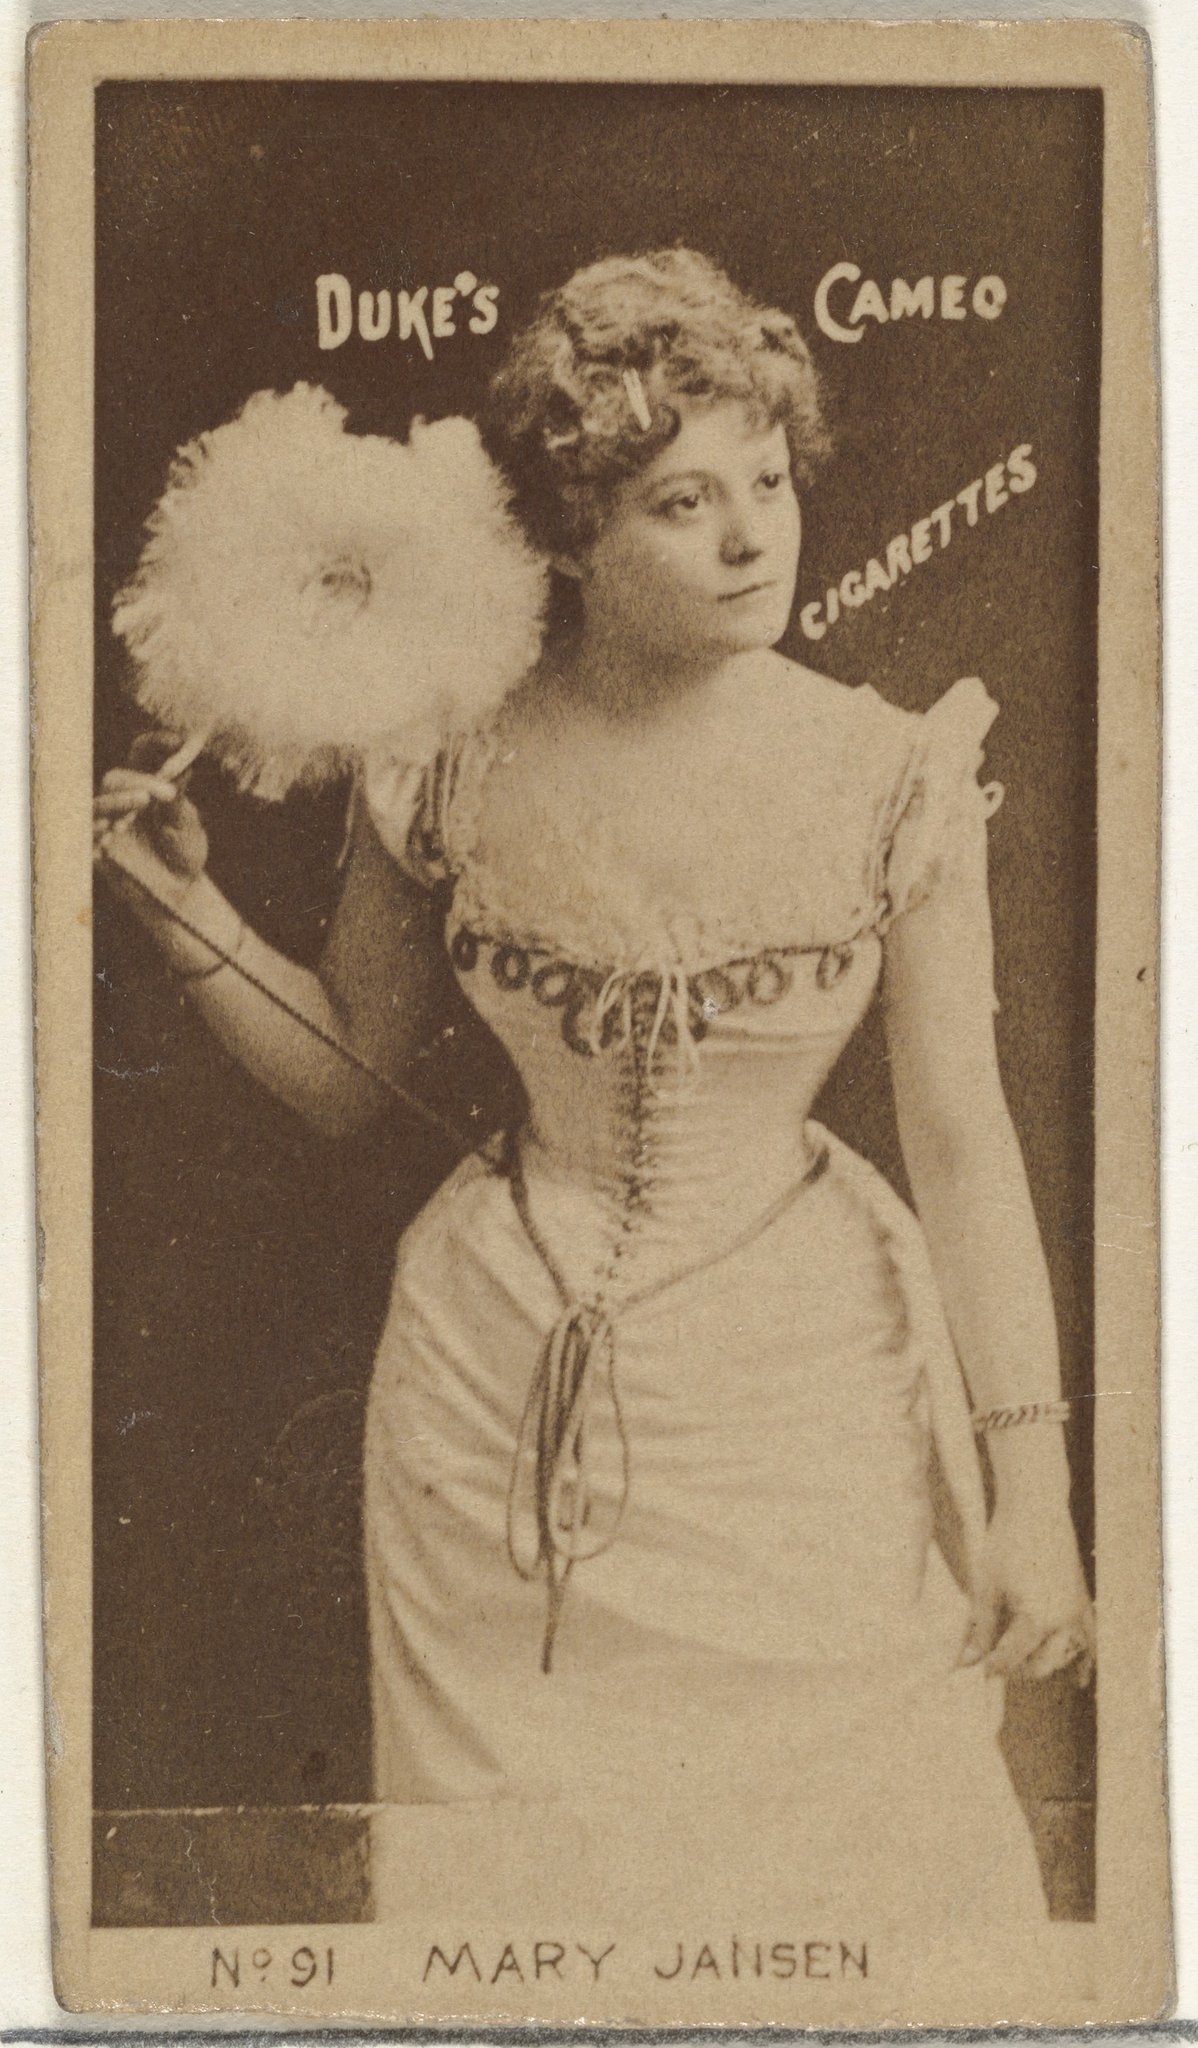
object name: photograph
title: Card Number 91, Marie Jansen, from the Actors and Actresses series (N145-4) issued by Duke Sons & Co. to promote Cameo Cigarettes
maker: w. duke, sons & co.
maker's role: publisher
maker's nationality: american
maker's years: 1870-1920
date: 1880-1889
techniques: albumen silver print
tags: portraits,women,actresses